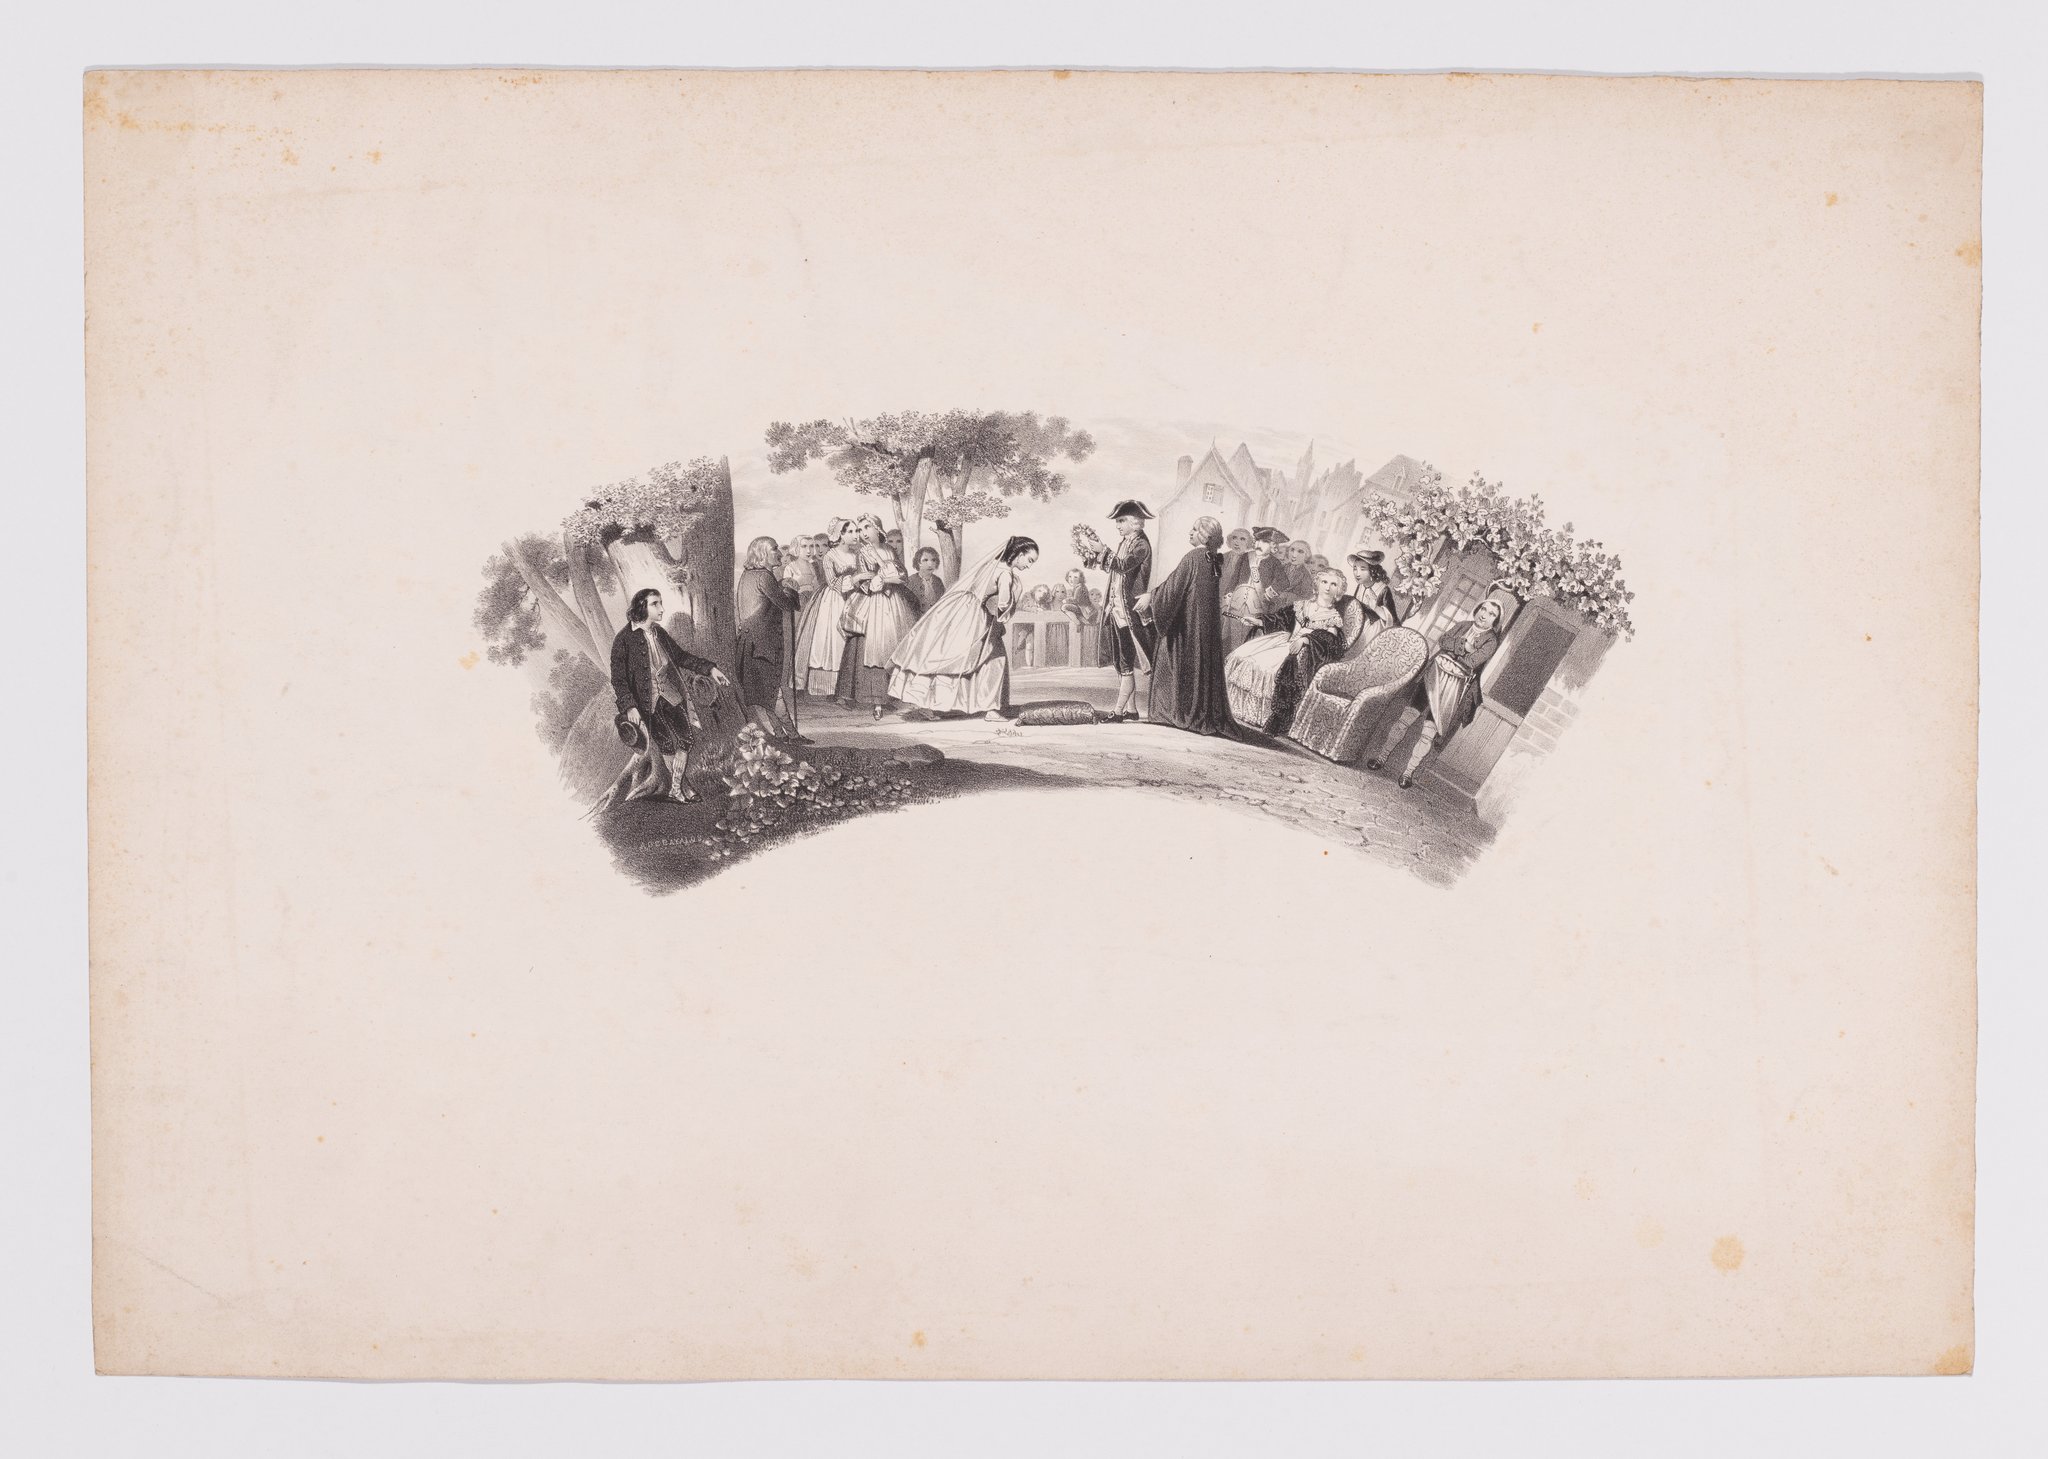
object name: print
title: Fan leaf with scene of a young lady being crowned with a flower wreath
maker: anonymous, spanish, 19th century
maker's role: artist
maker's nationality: spanish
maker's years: 1800-1900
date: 1801-1900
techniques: lithograph